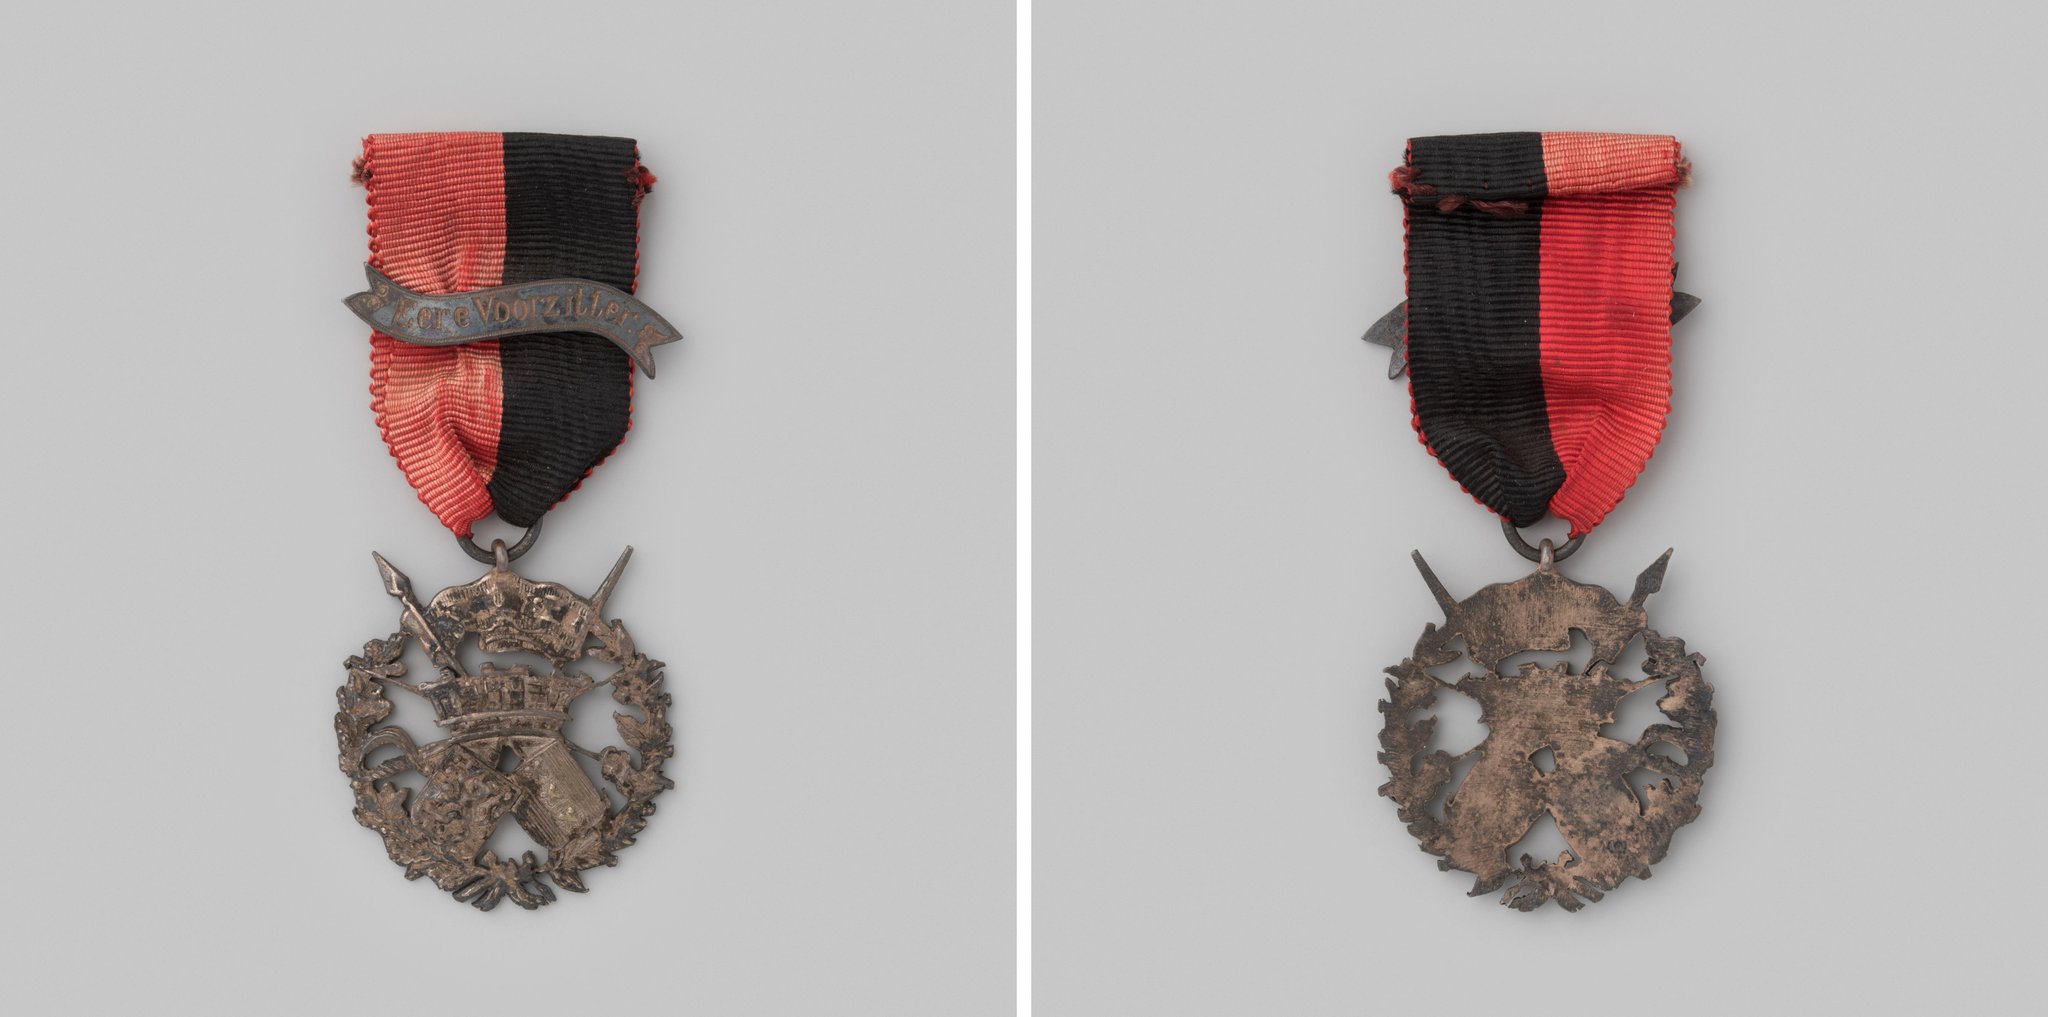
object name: medal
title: Draagteken van de Vereeniging van de onderofficieren van de Schutterij te Amsterdam tot oefening in de wapenhandel (V.O.S.A.)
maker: Anonymous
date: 1882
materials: silver, textile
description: Zilveren draagteken met oog, ring en lint, met op het lint een zilveren band waarop gegraveerd VOORZITTER.